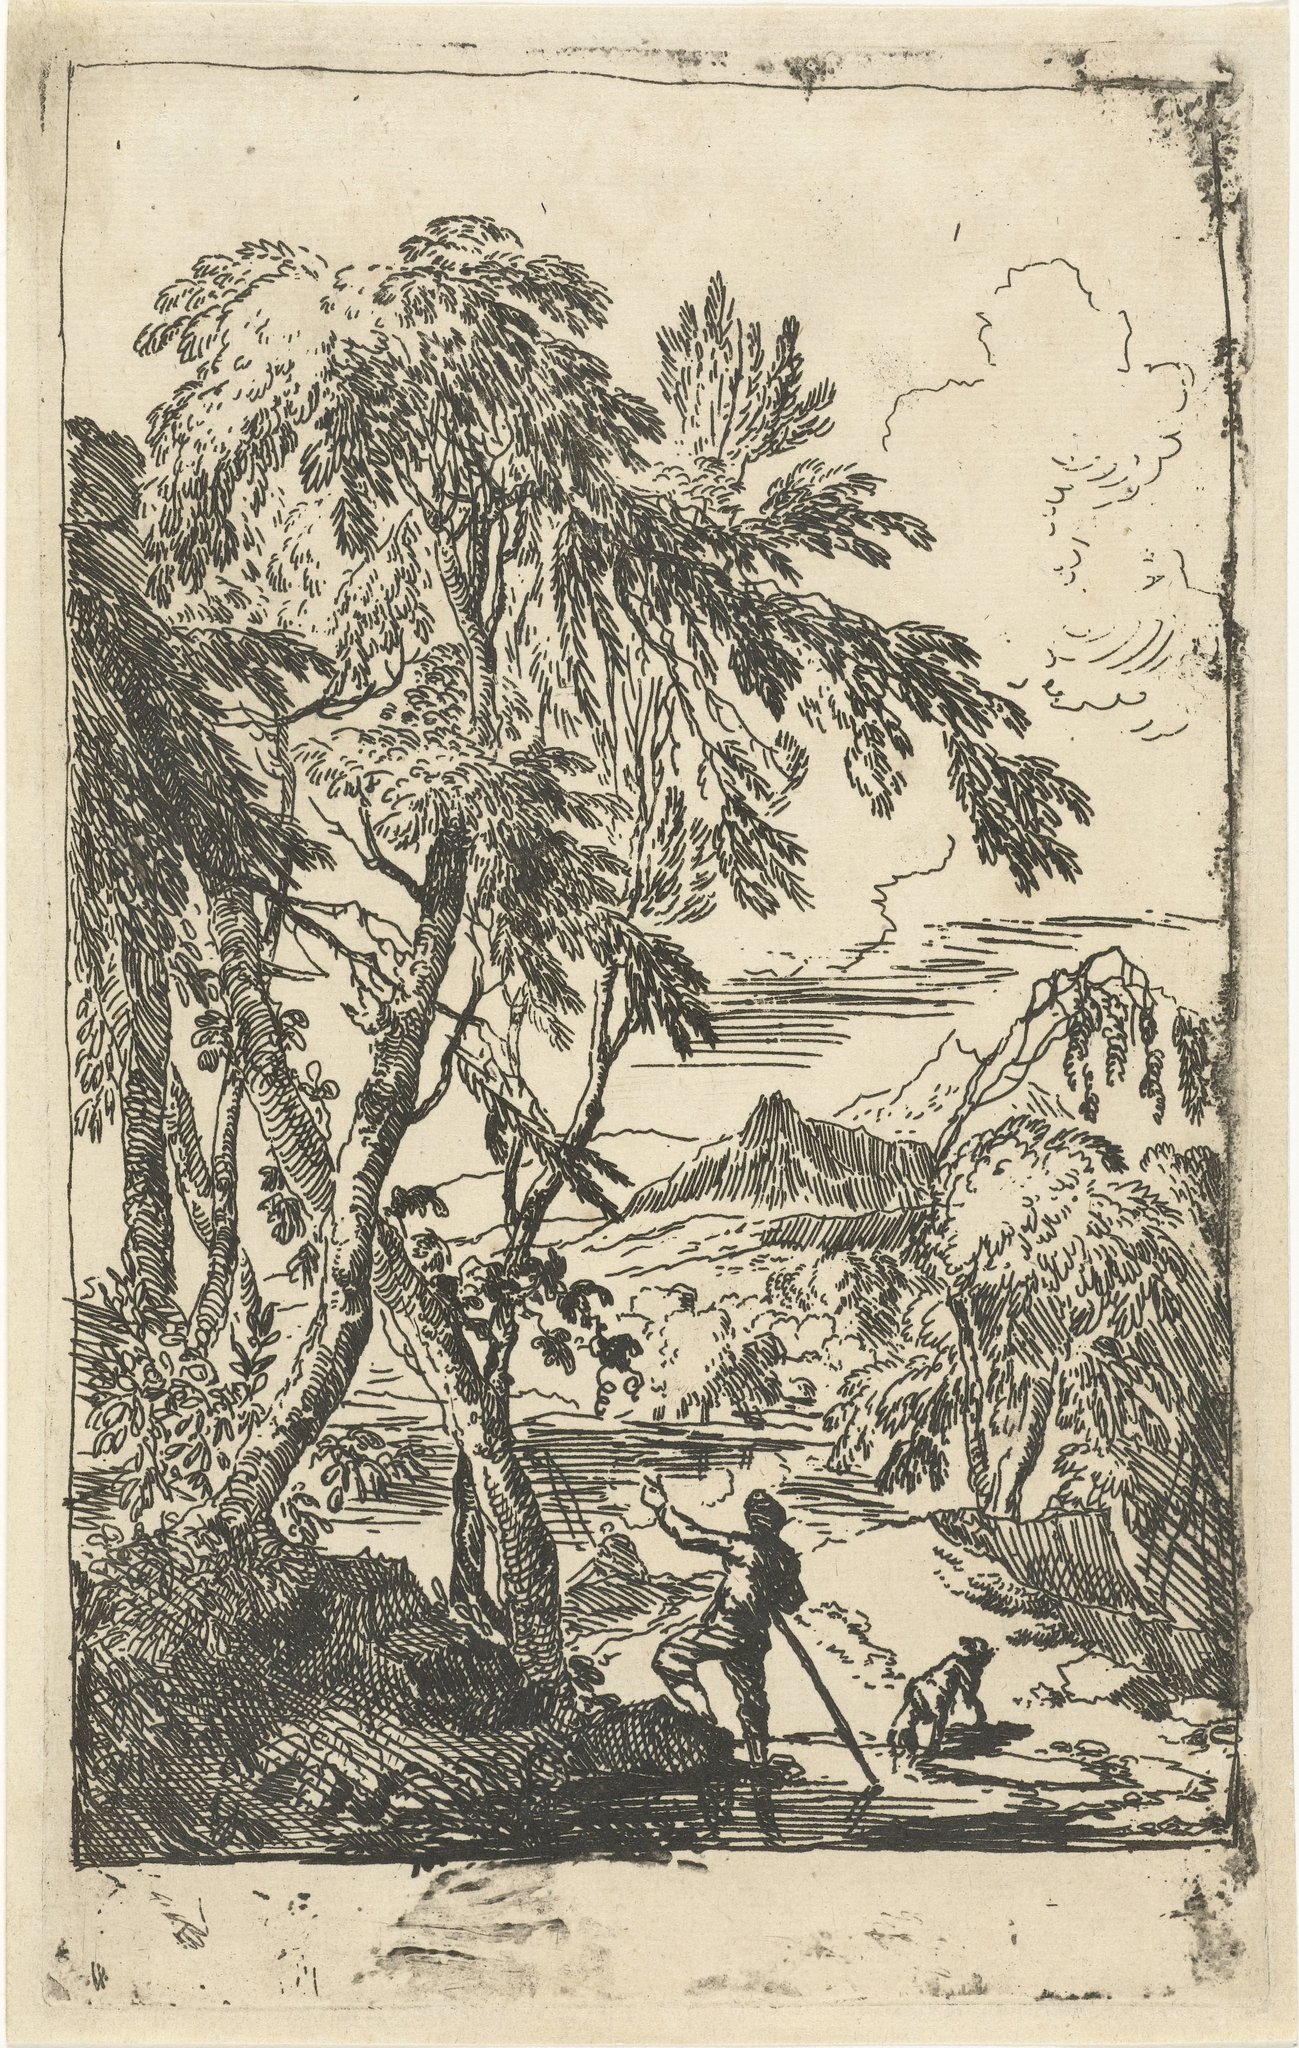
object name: print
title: Bergachtig landschap met bomen en man met hond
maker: adriaen van diest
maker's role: painter, print maker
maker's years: 1655-1704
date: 1665-1690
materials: paper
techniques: etching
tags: mountains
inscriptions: collector's mark: Lugt 2228, collector's mark: Lugt 2760